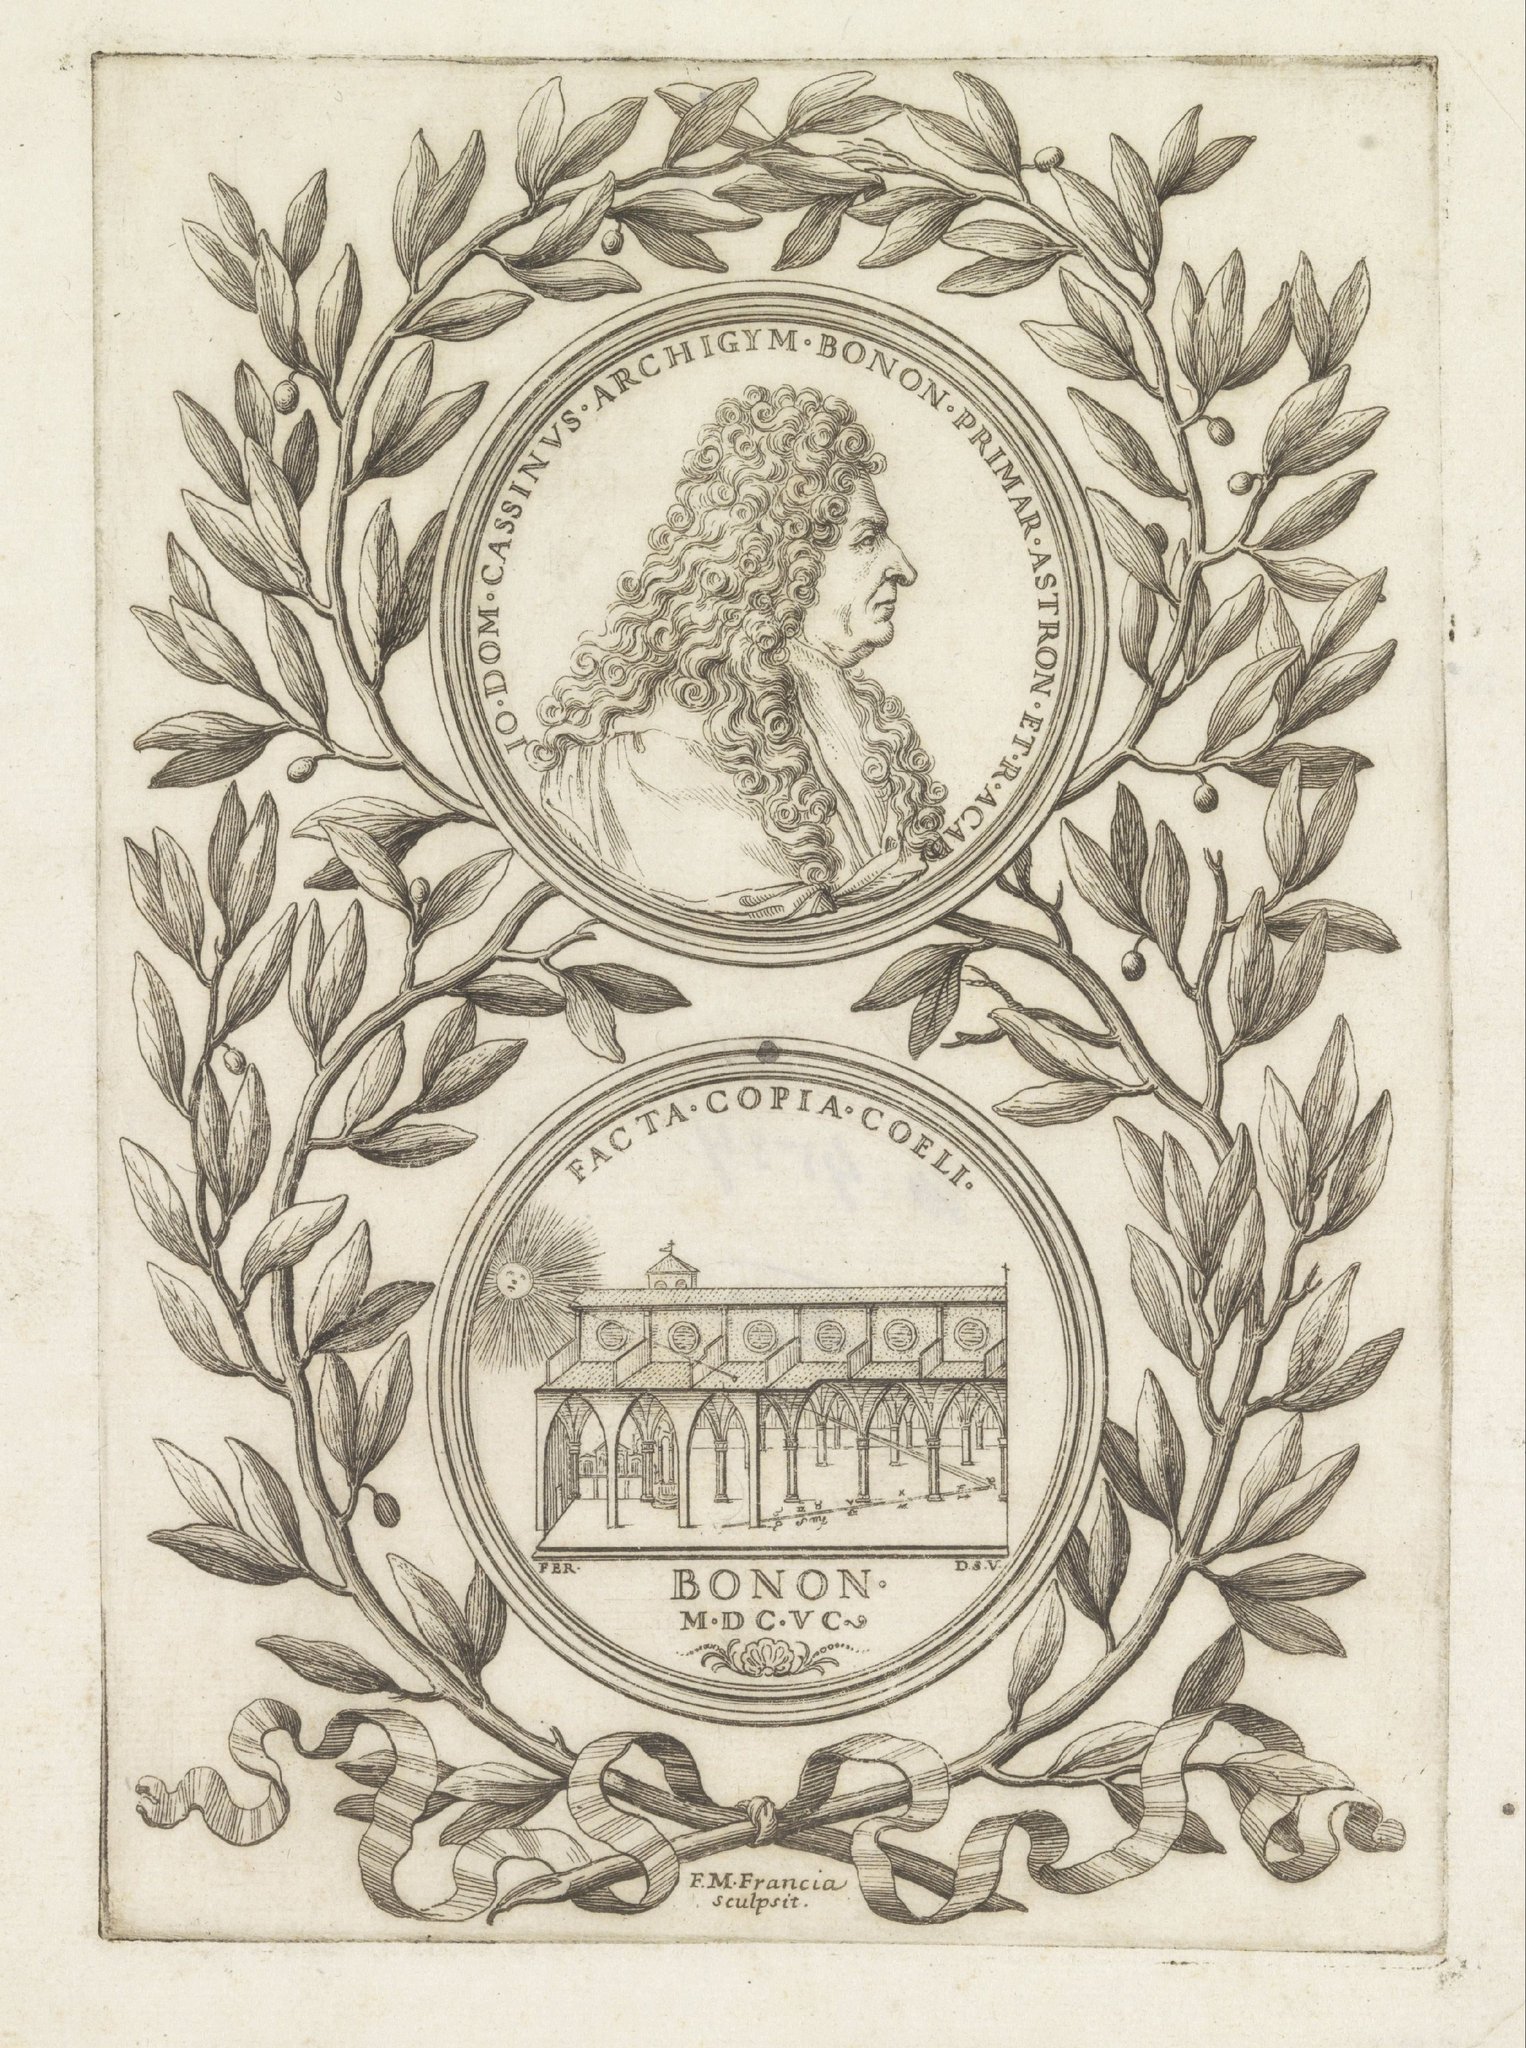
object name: print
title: Portret van Giovanni Domenico Cassini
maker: francesco maria francia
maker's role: print maker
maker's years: 1657-1735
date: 1667-1735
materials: paper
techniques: etching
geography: italy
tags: historical persons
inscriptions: collector's mark: Lugt 2228